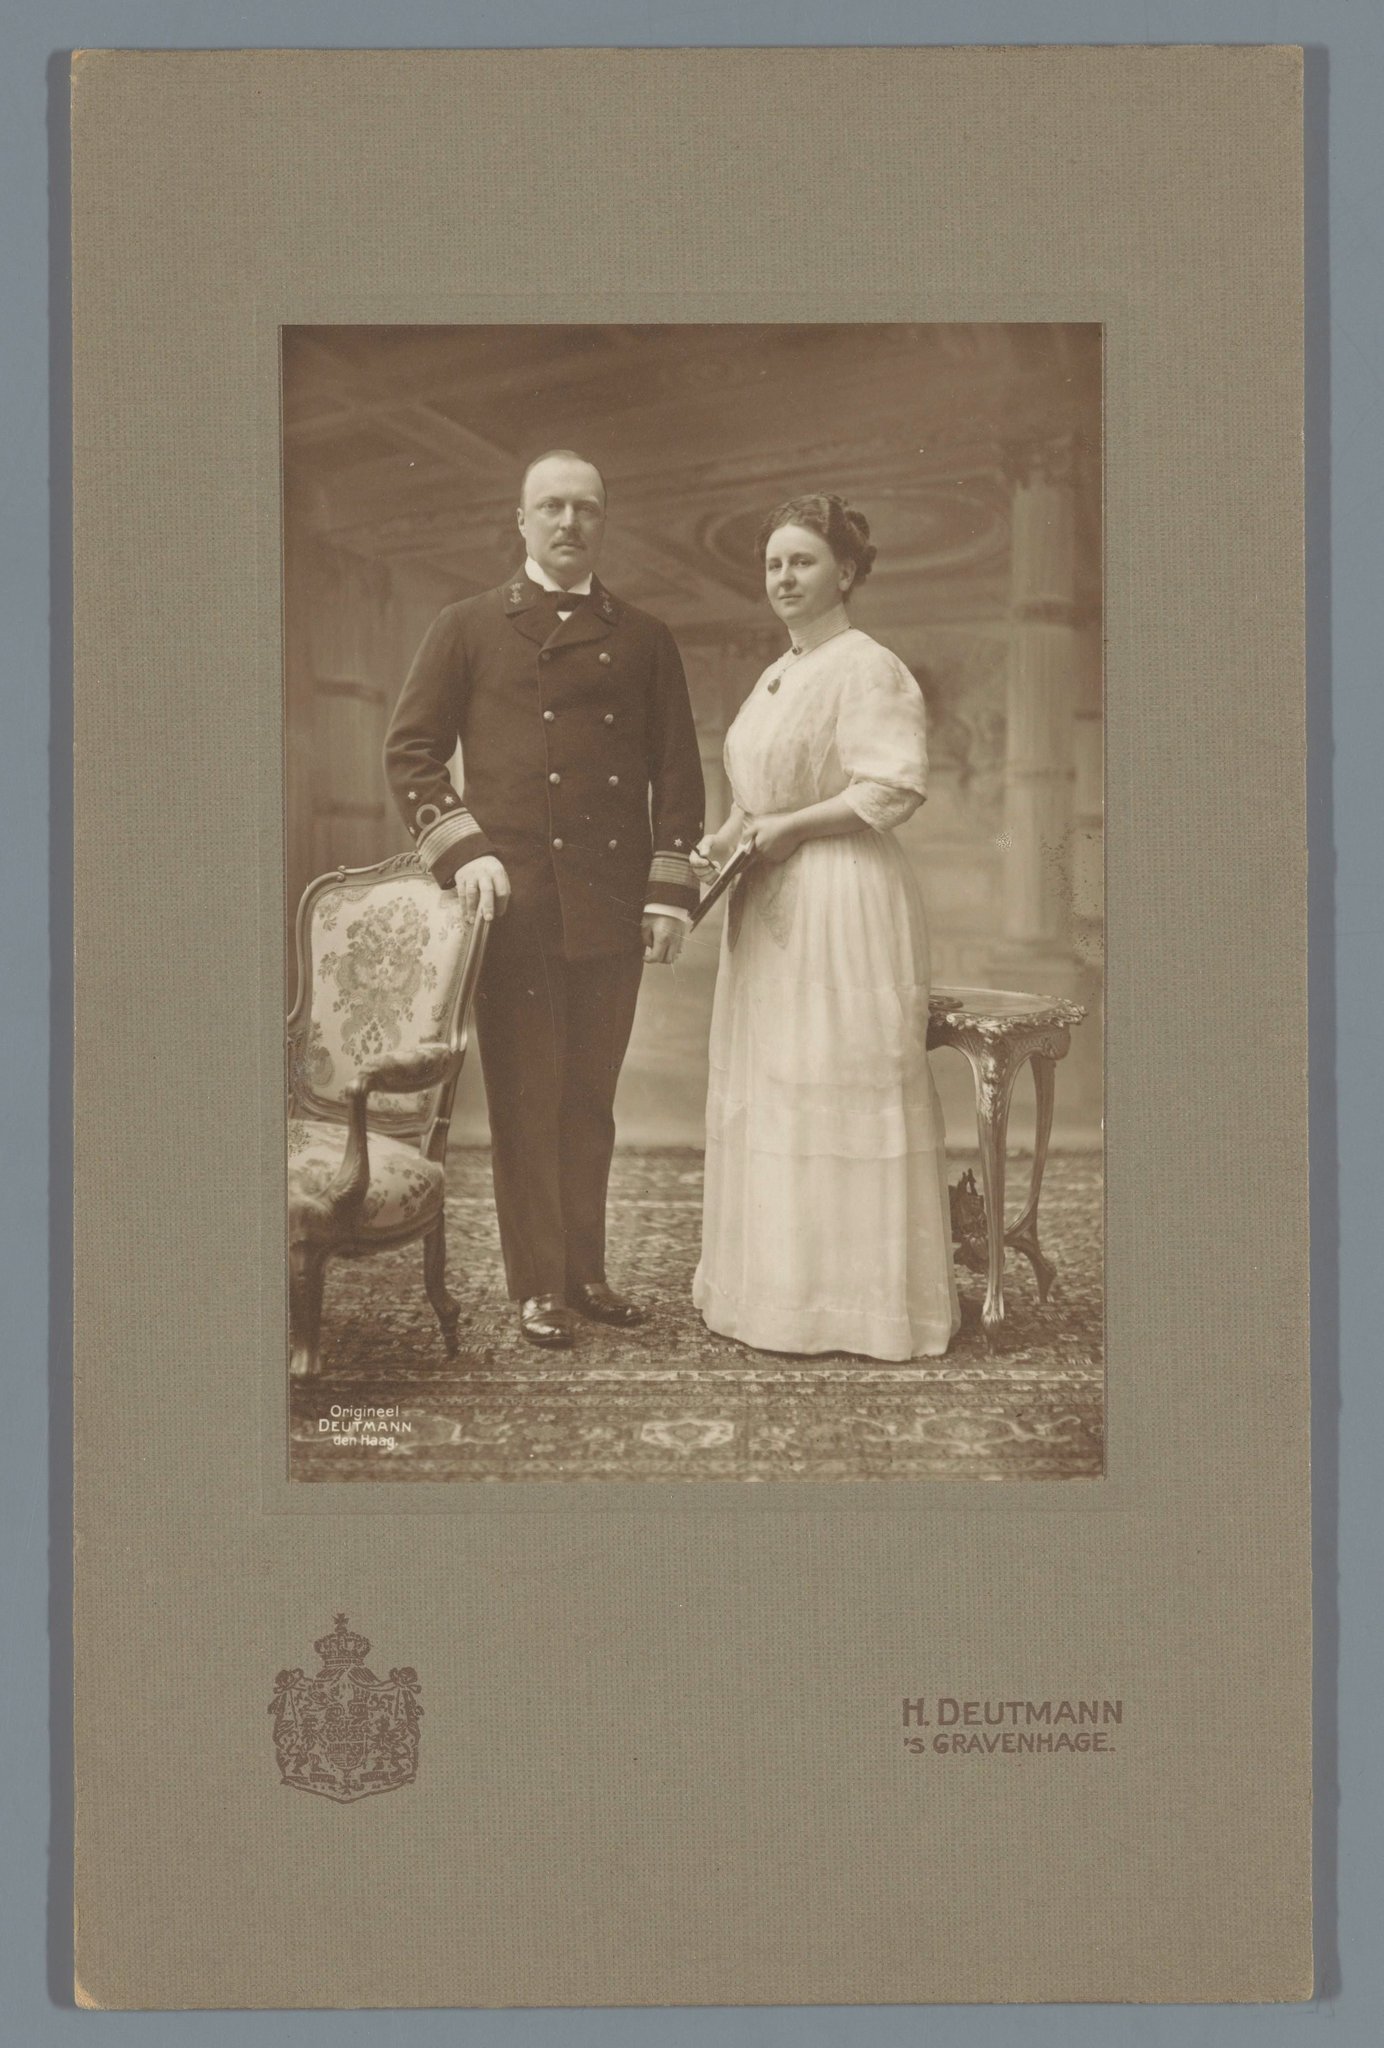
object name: cabinet photograph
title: Portret van koningin Wilhelmina en prins Hendrik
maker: herman deutmann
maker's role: fotograaf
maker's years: 1870-1926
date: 1912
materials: cardboard, photographic support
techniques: matte daylight collodion silver print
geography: the hague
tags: the hague, print maker, wilhelmina of the netherlands, hendrik (prins der nederlanden (1876-1934)), prince, historical persons, queen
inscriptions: inscription: ‘Wilhelmina en Hendrik/ 31-8-1912’, name: ‘H. DEUTMANN/ 'S GRAVENHAGE.’, number: ‘40’